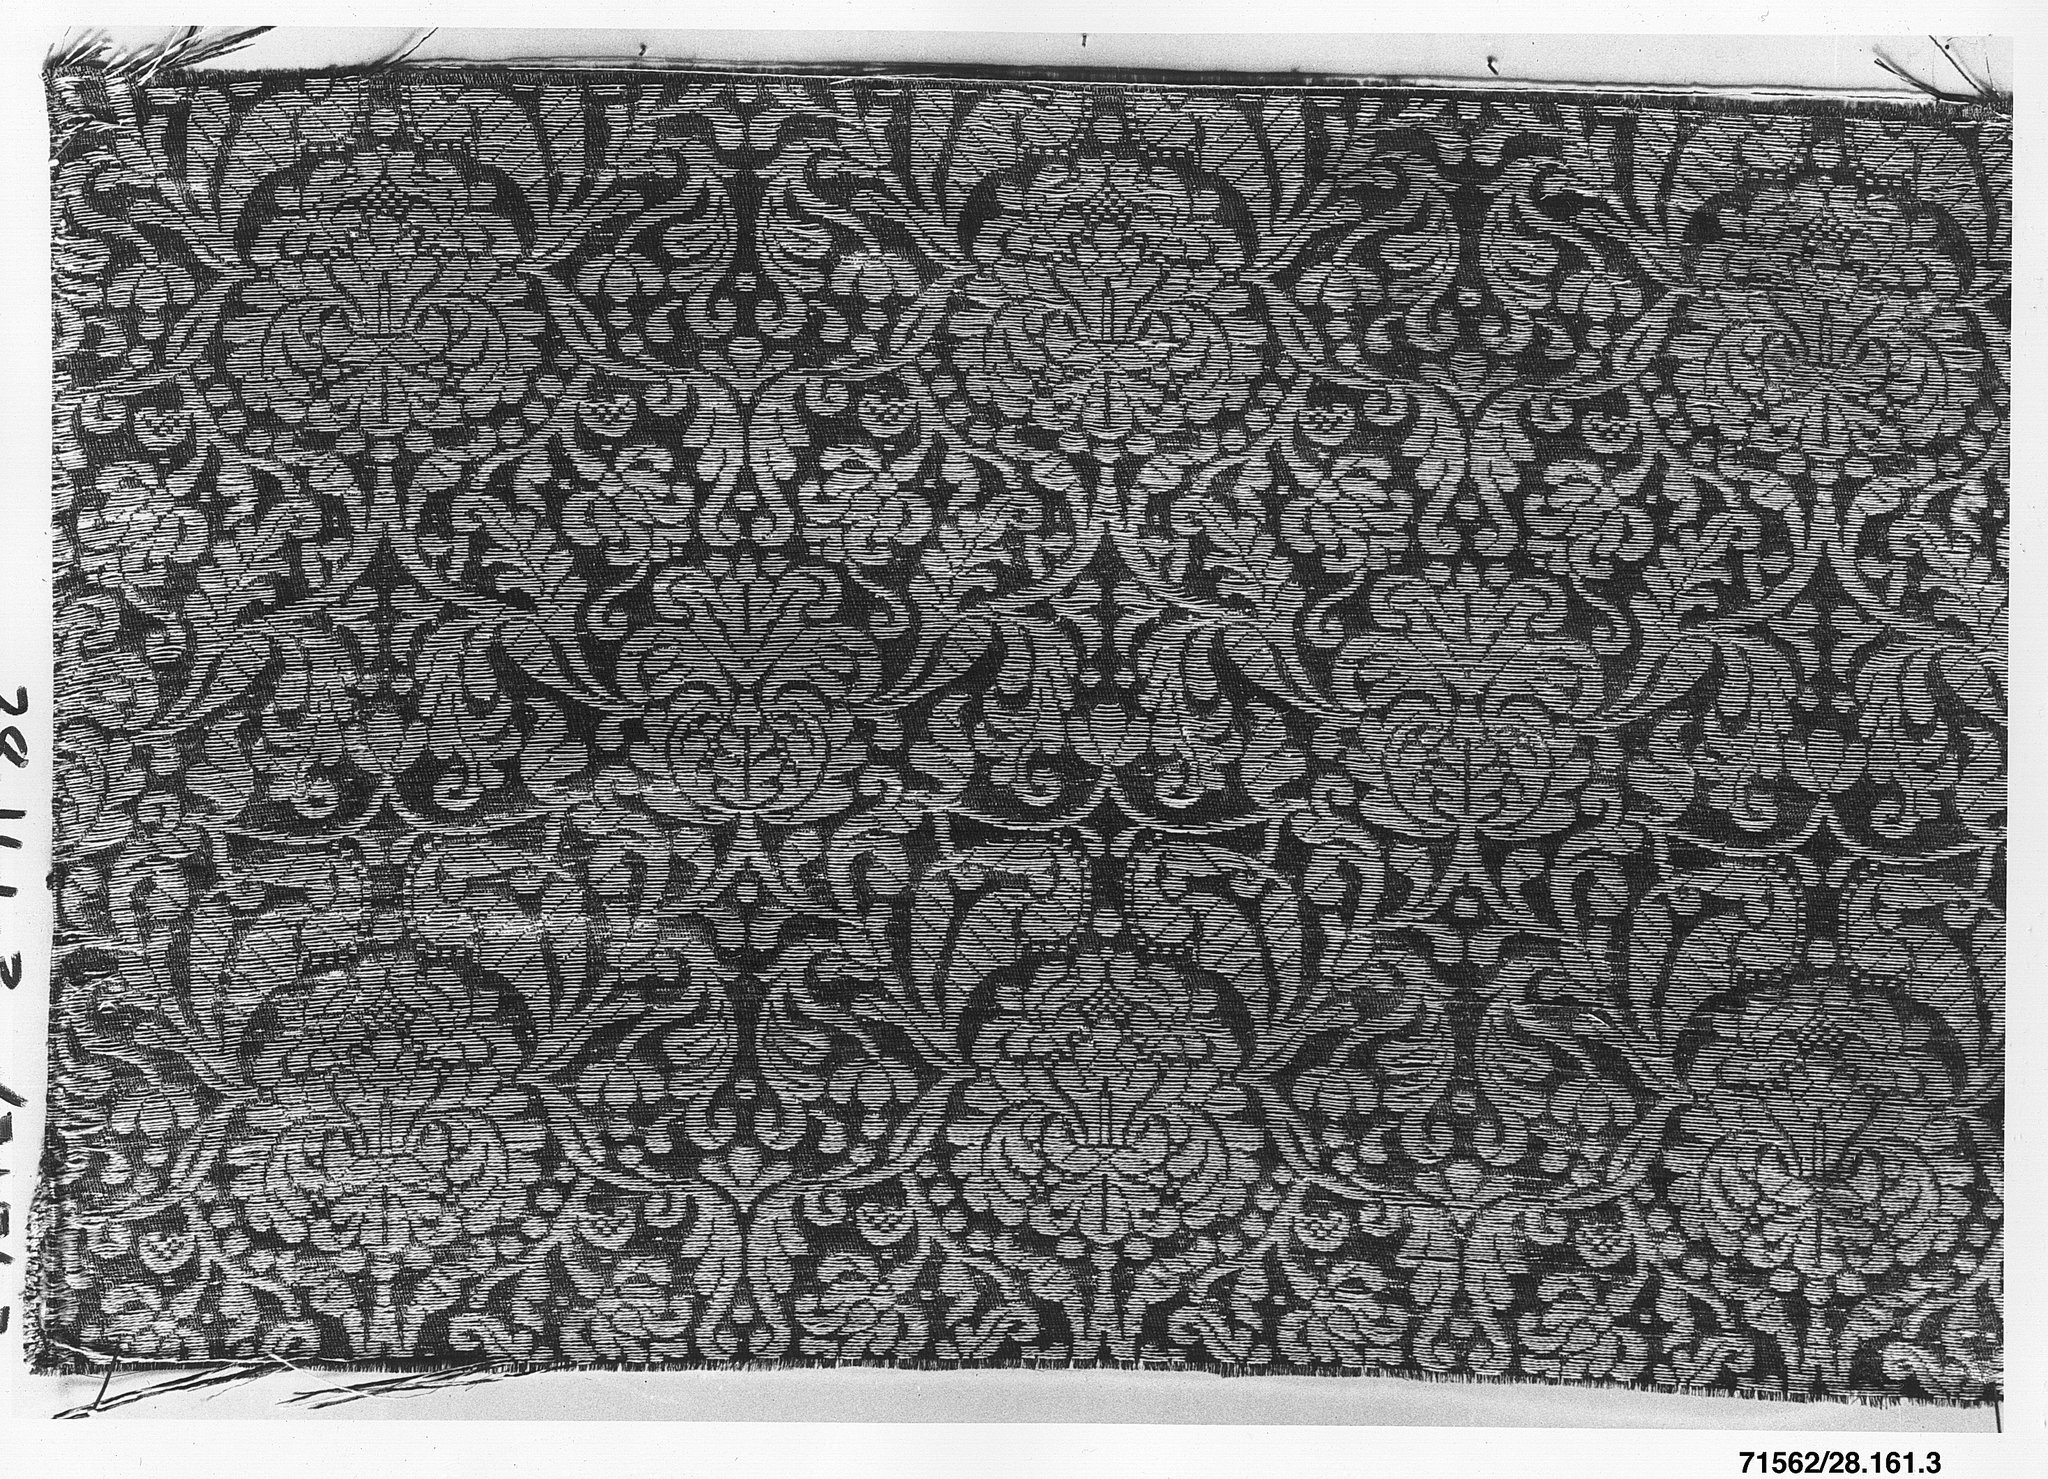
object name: piece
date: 1640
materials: metal thread, silk